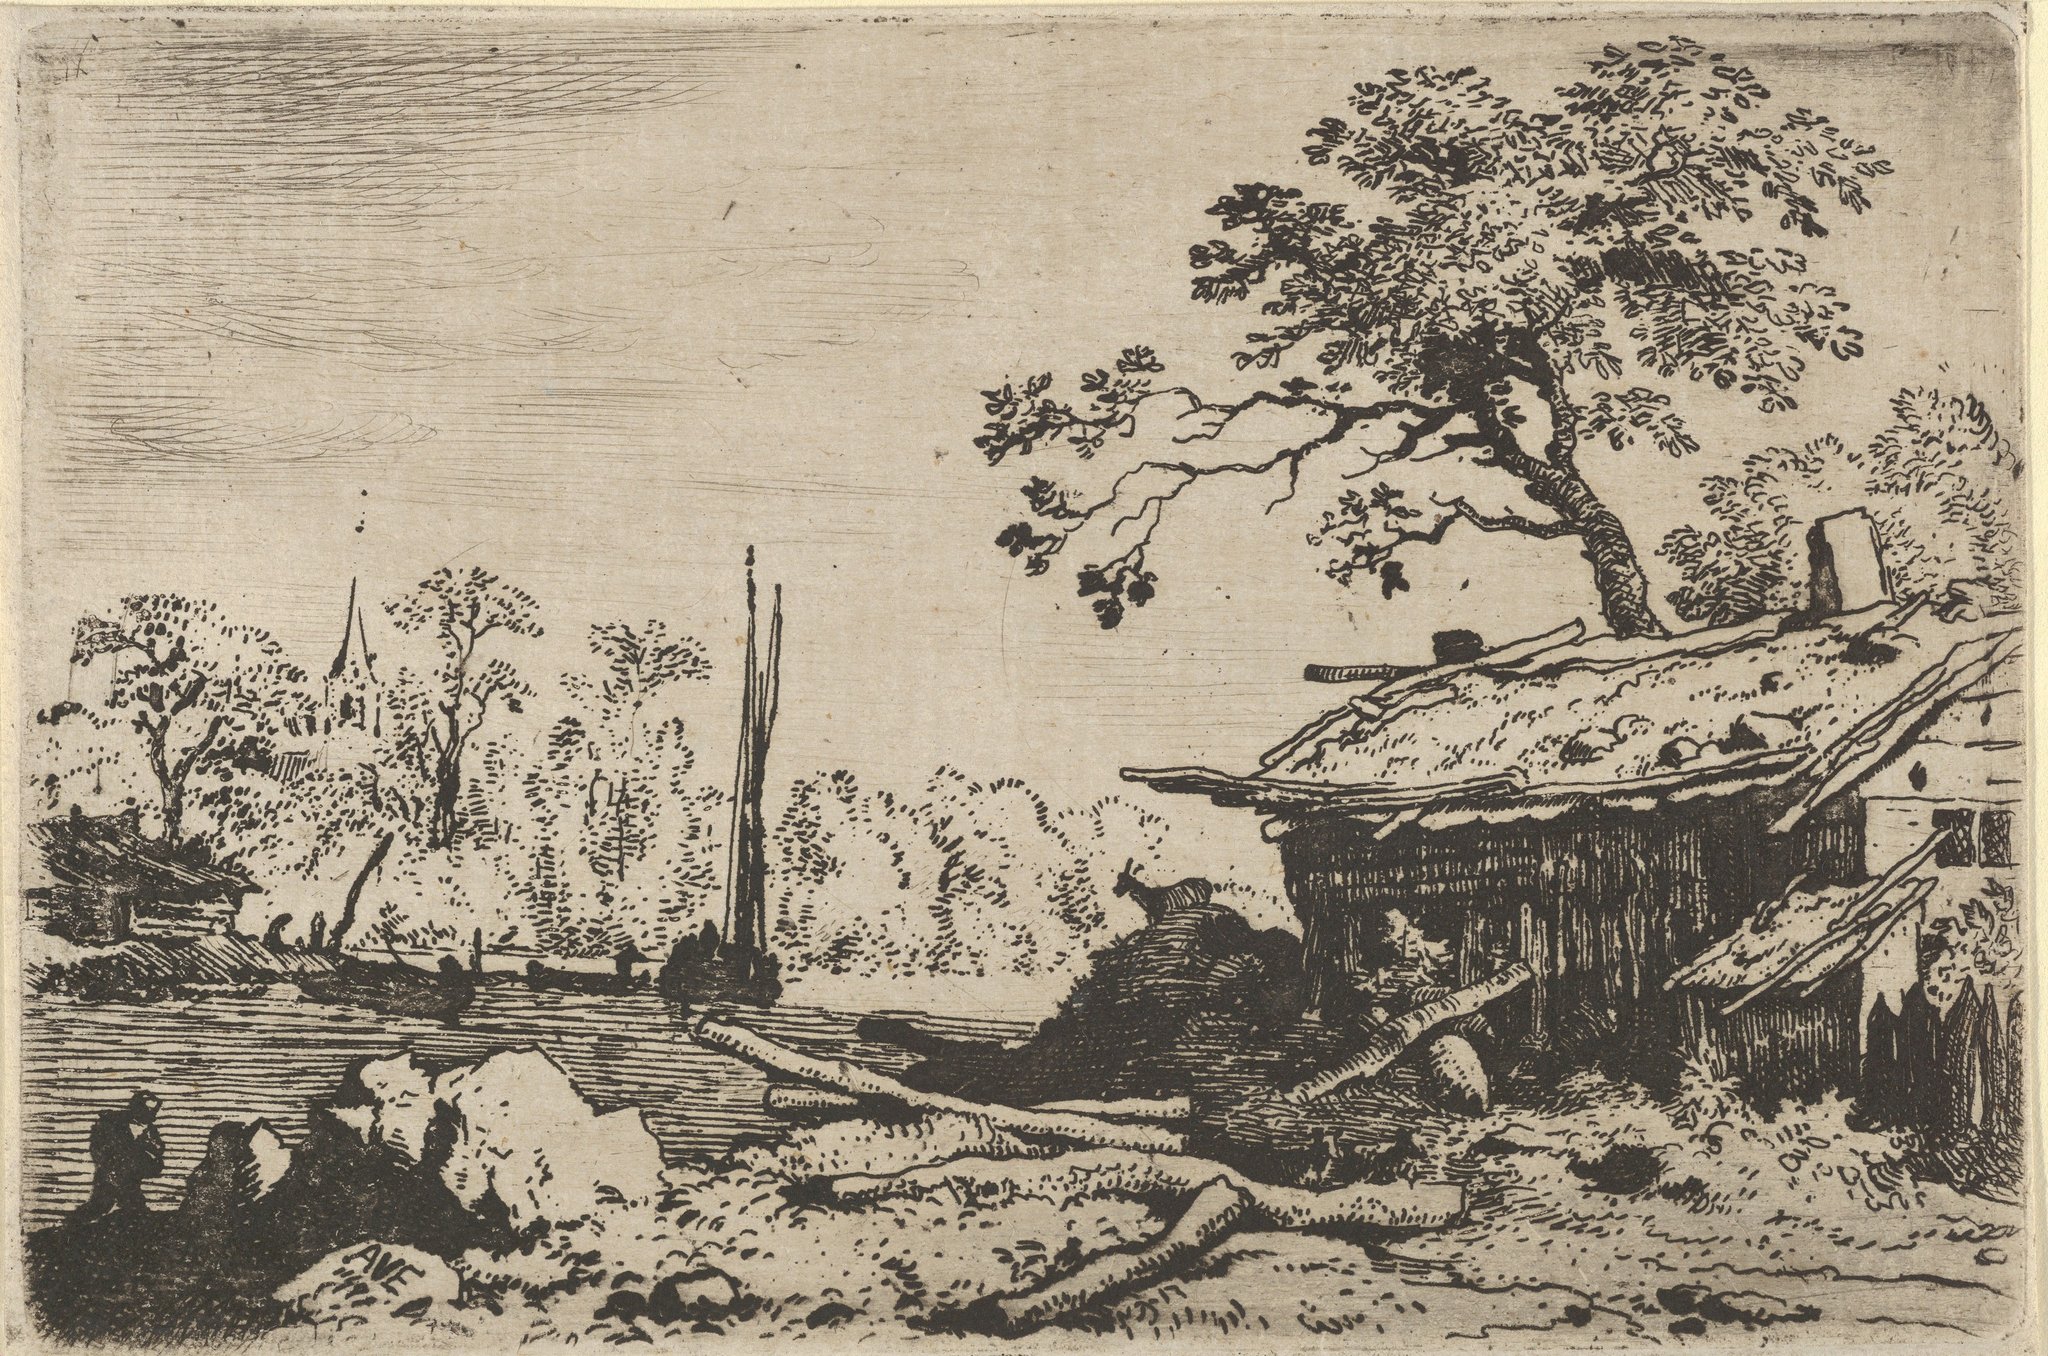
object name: print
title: The Ruinous Hut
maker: allart van everdingen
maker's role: artist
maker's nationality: dutch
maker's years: 1621-1675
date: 1621-1675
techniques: engraving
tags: ruins